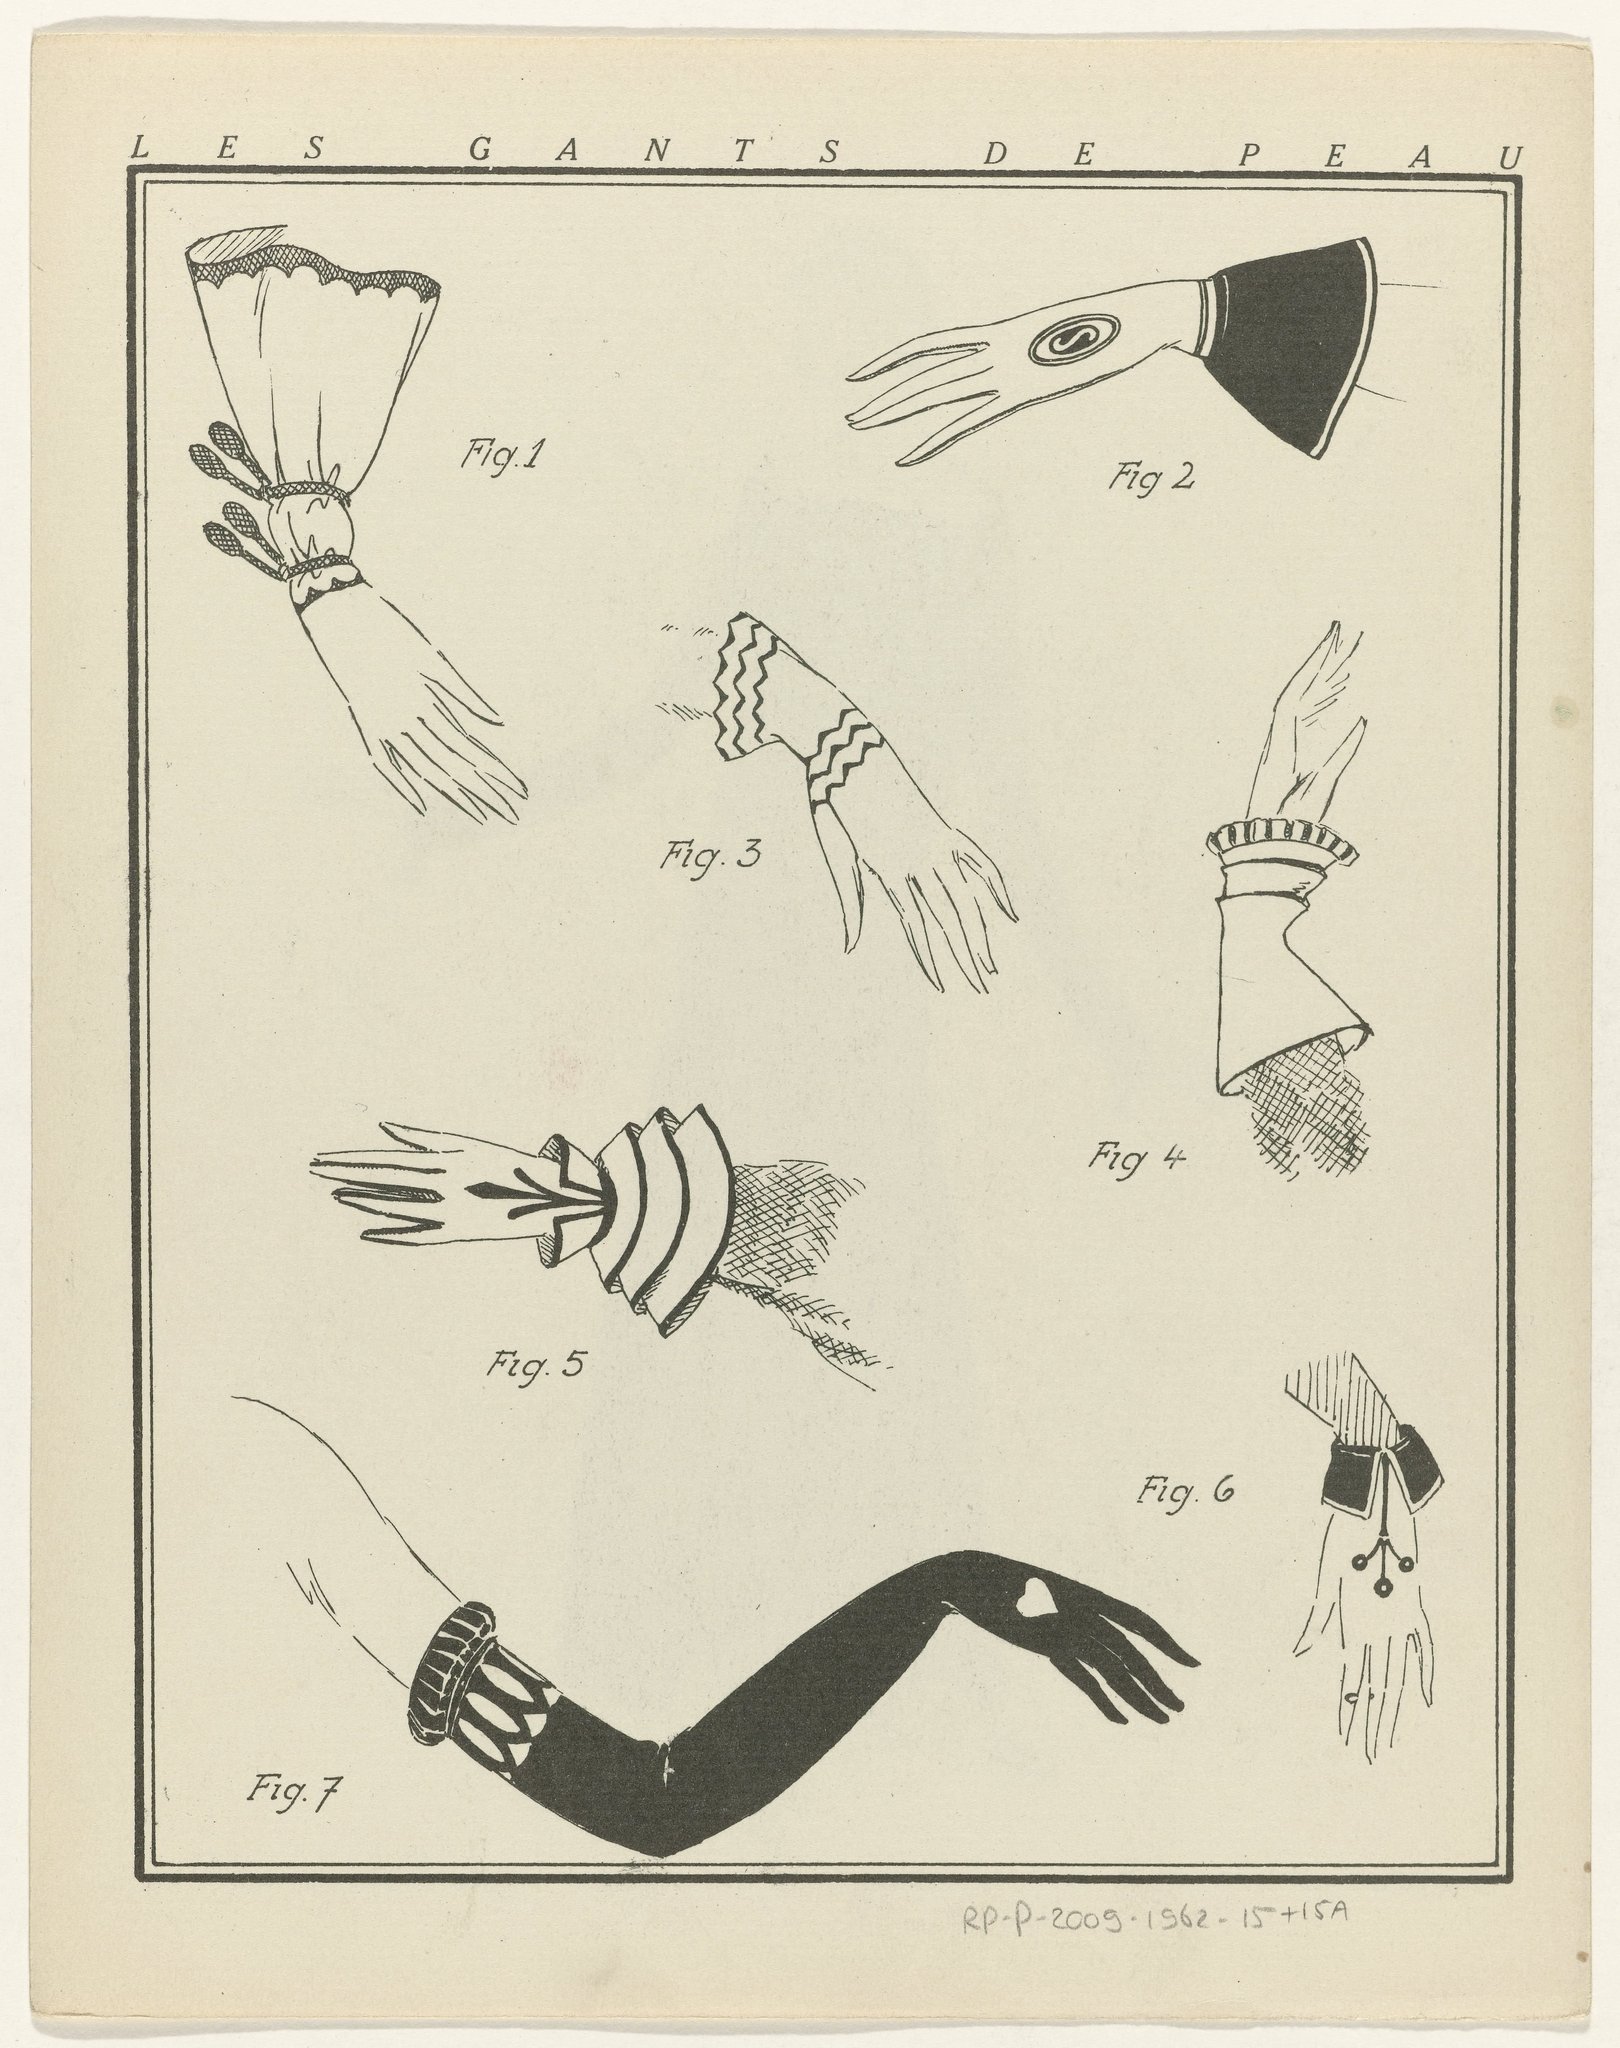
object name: fashion print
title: Accessories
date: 1922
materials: paper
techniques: letterpress printing, lithograph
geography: paris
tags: fashion plates, gloves, mittens, etc. (+ women's clothes)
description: Fans, parasols, opera gloves, fashionable hats, small toques garnished with feathers, wristwatches, compact bracelets, and luxuriously crafted lighters: there was a dazzling variety of accessories in the 1920s. Small bags could be suspended from a belt, or a glove. Walking sticks and the shafts of umbrellas and parasols were often embellished with carving clearly inspired by African and Indian art. And Russian influence was evident when it came to combs made of mother-of-pearl and ivory.